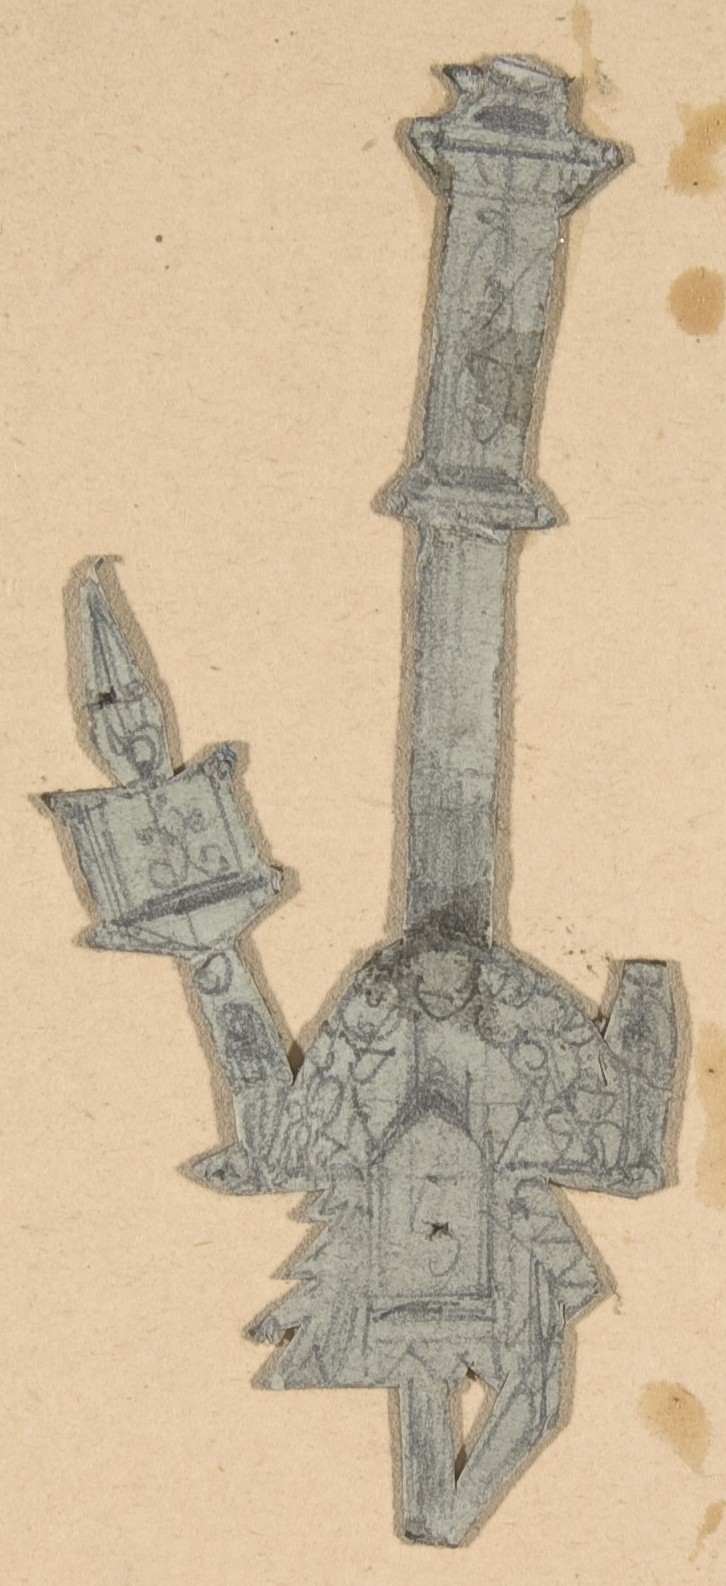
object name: drawing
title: Design for a Stage Set at the Opéra, Paris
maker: eugène cicéri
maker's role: artist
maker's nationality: french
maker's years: 1813-1890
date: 1830-1890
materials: graphite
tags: stage design